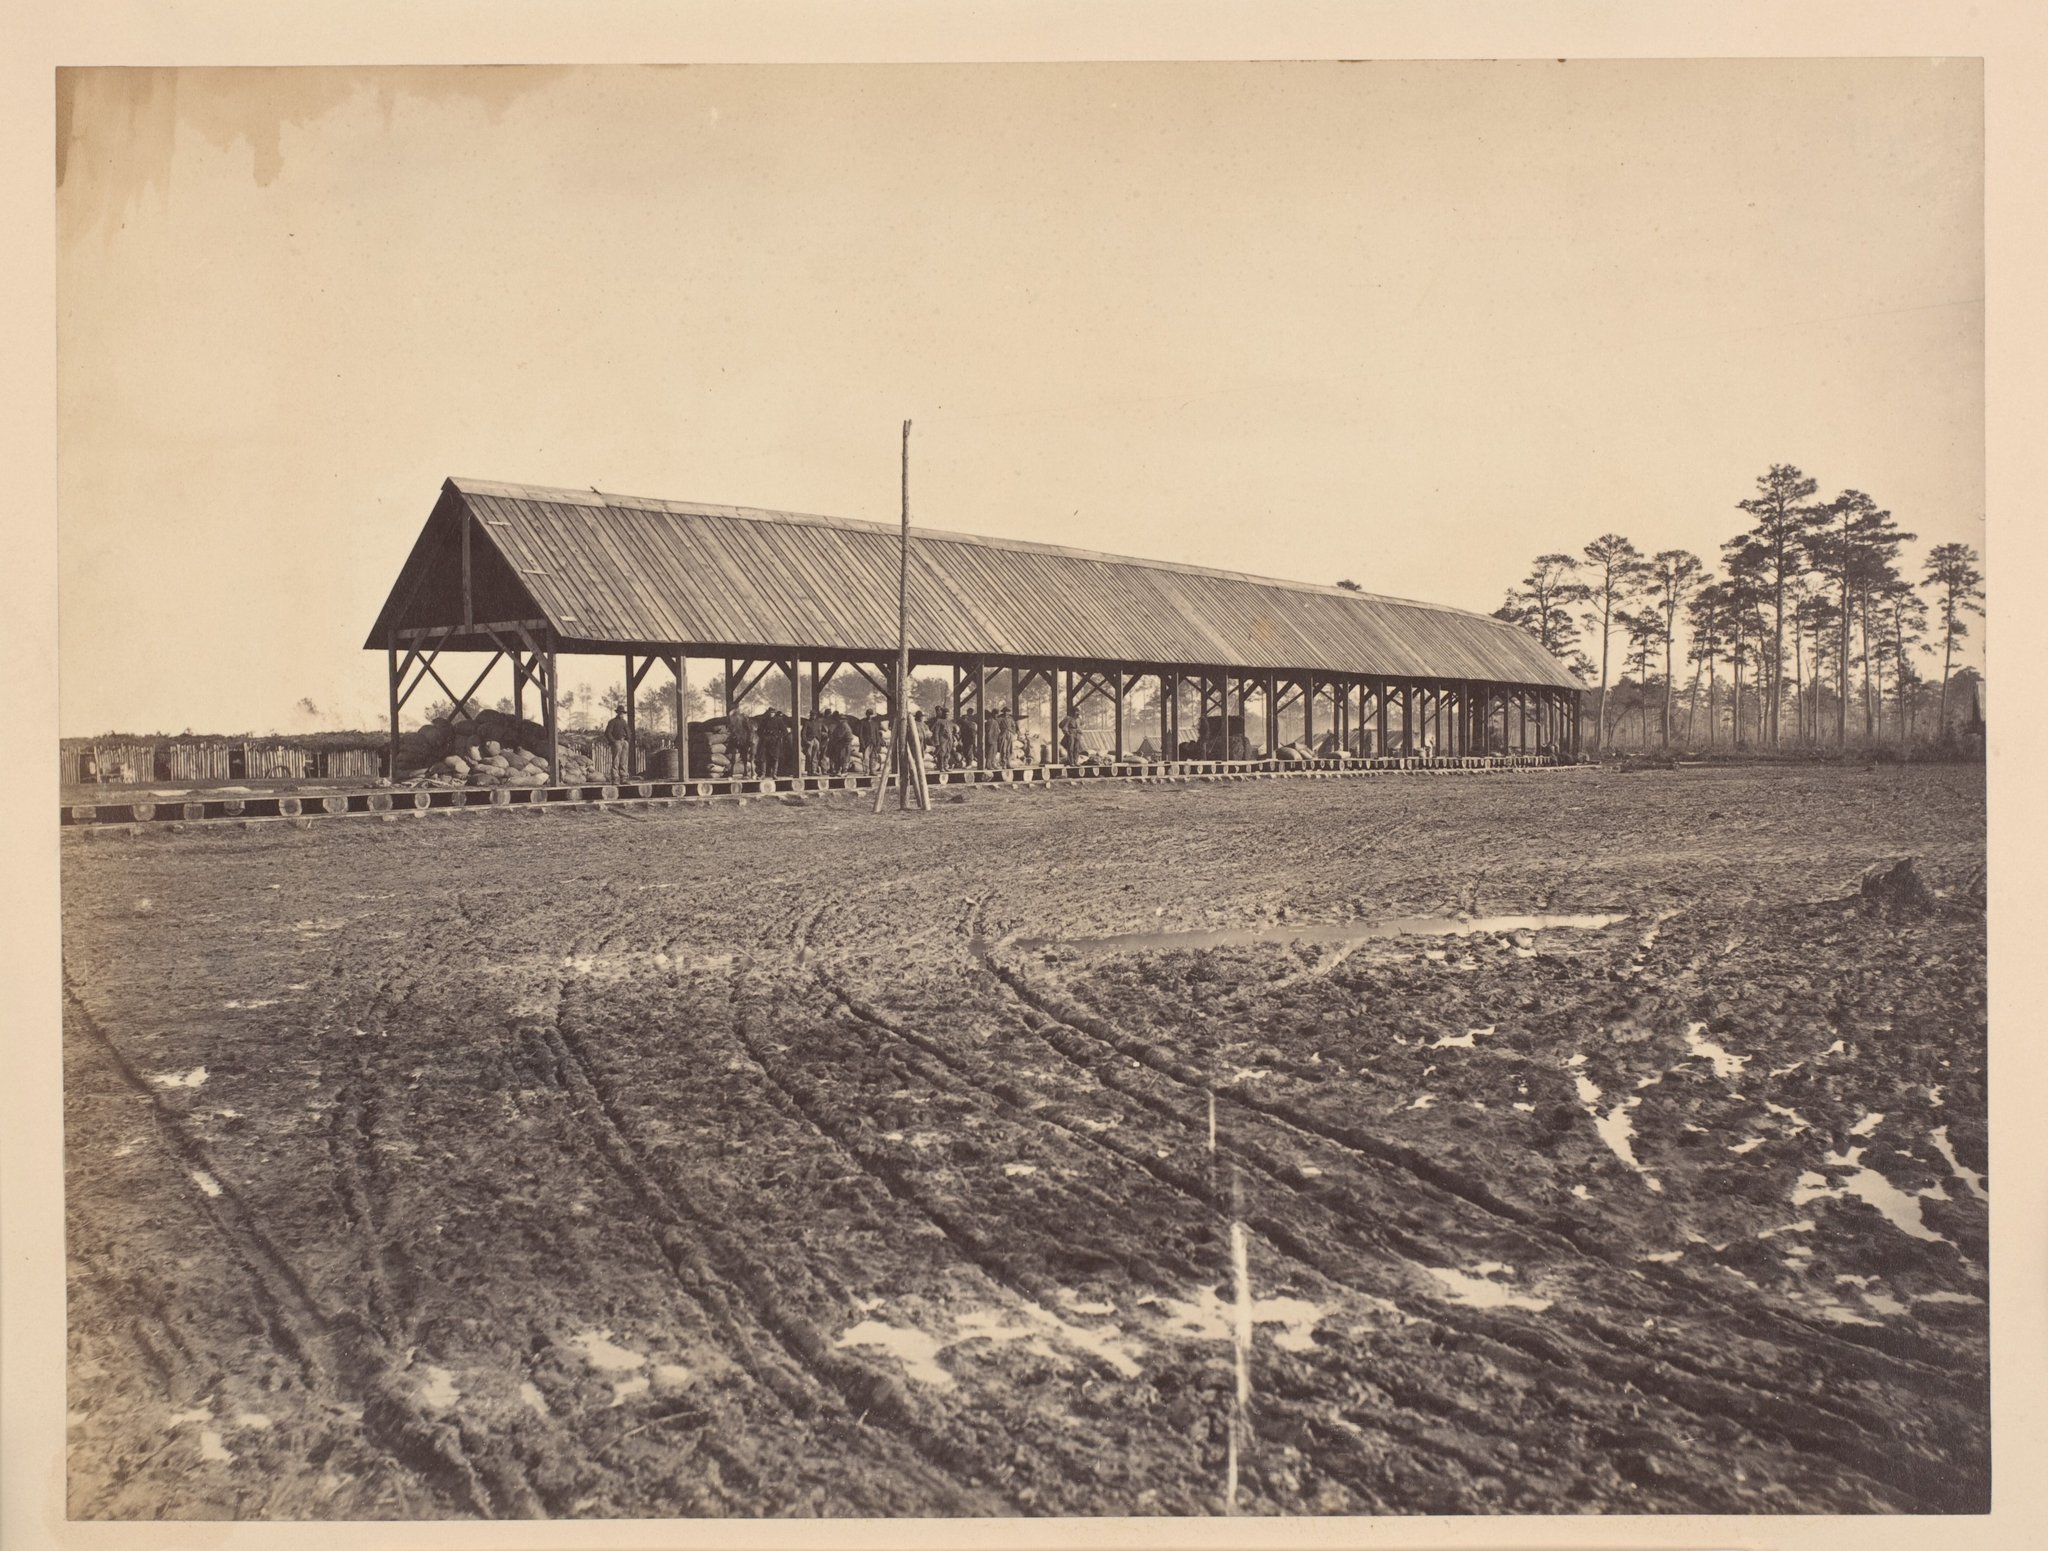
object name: photograph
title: [Civil War View]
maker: thomas c. roche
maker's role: artist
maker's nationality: american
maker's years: 1826-1895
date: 1860-1869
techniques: albumen silver print, glass negative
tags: buildings,american civil war